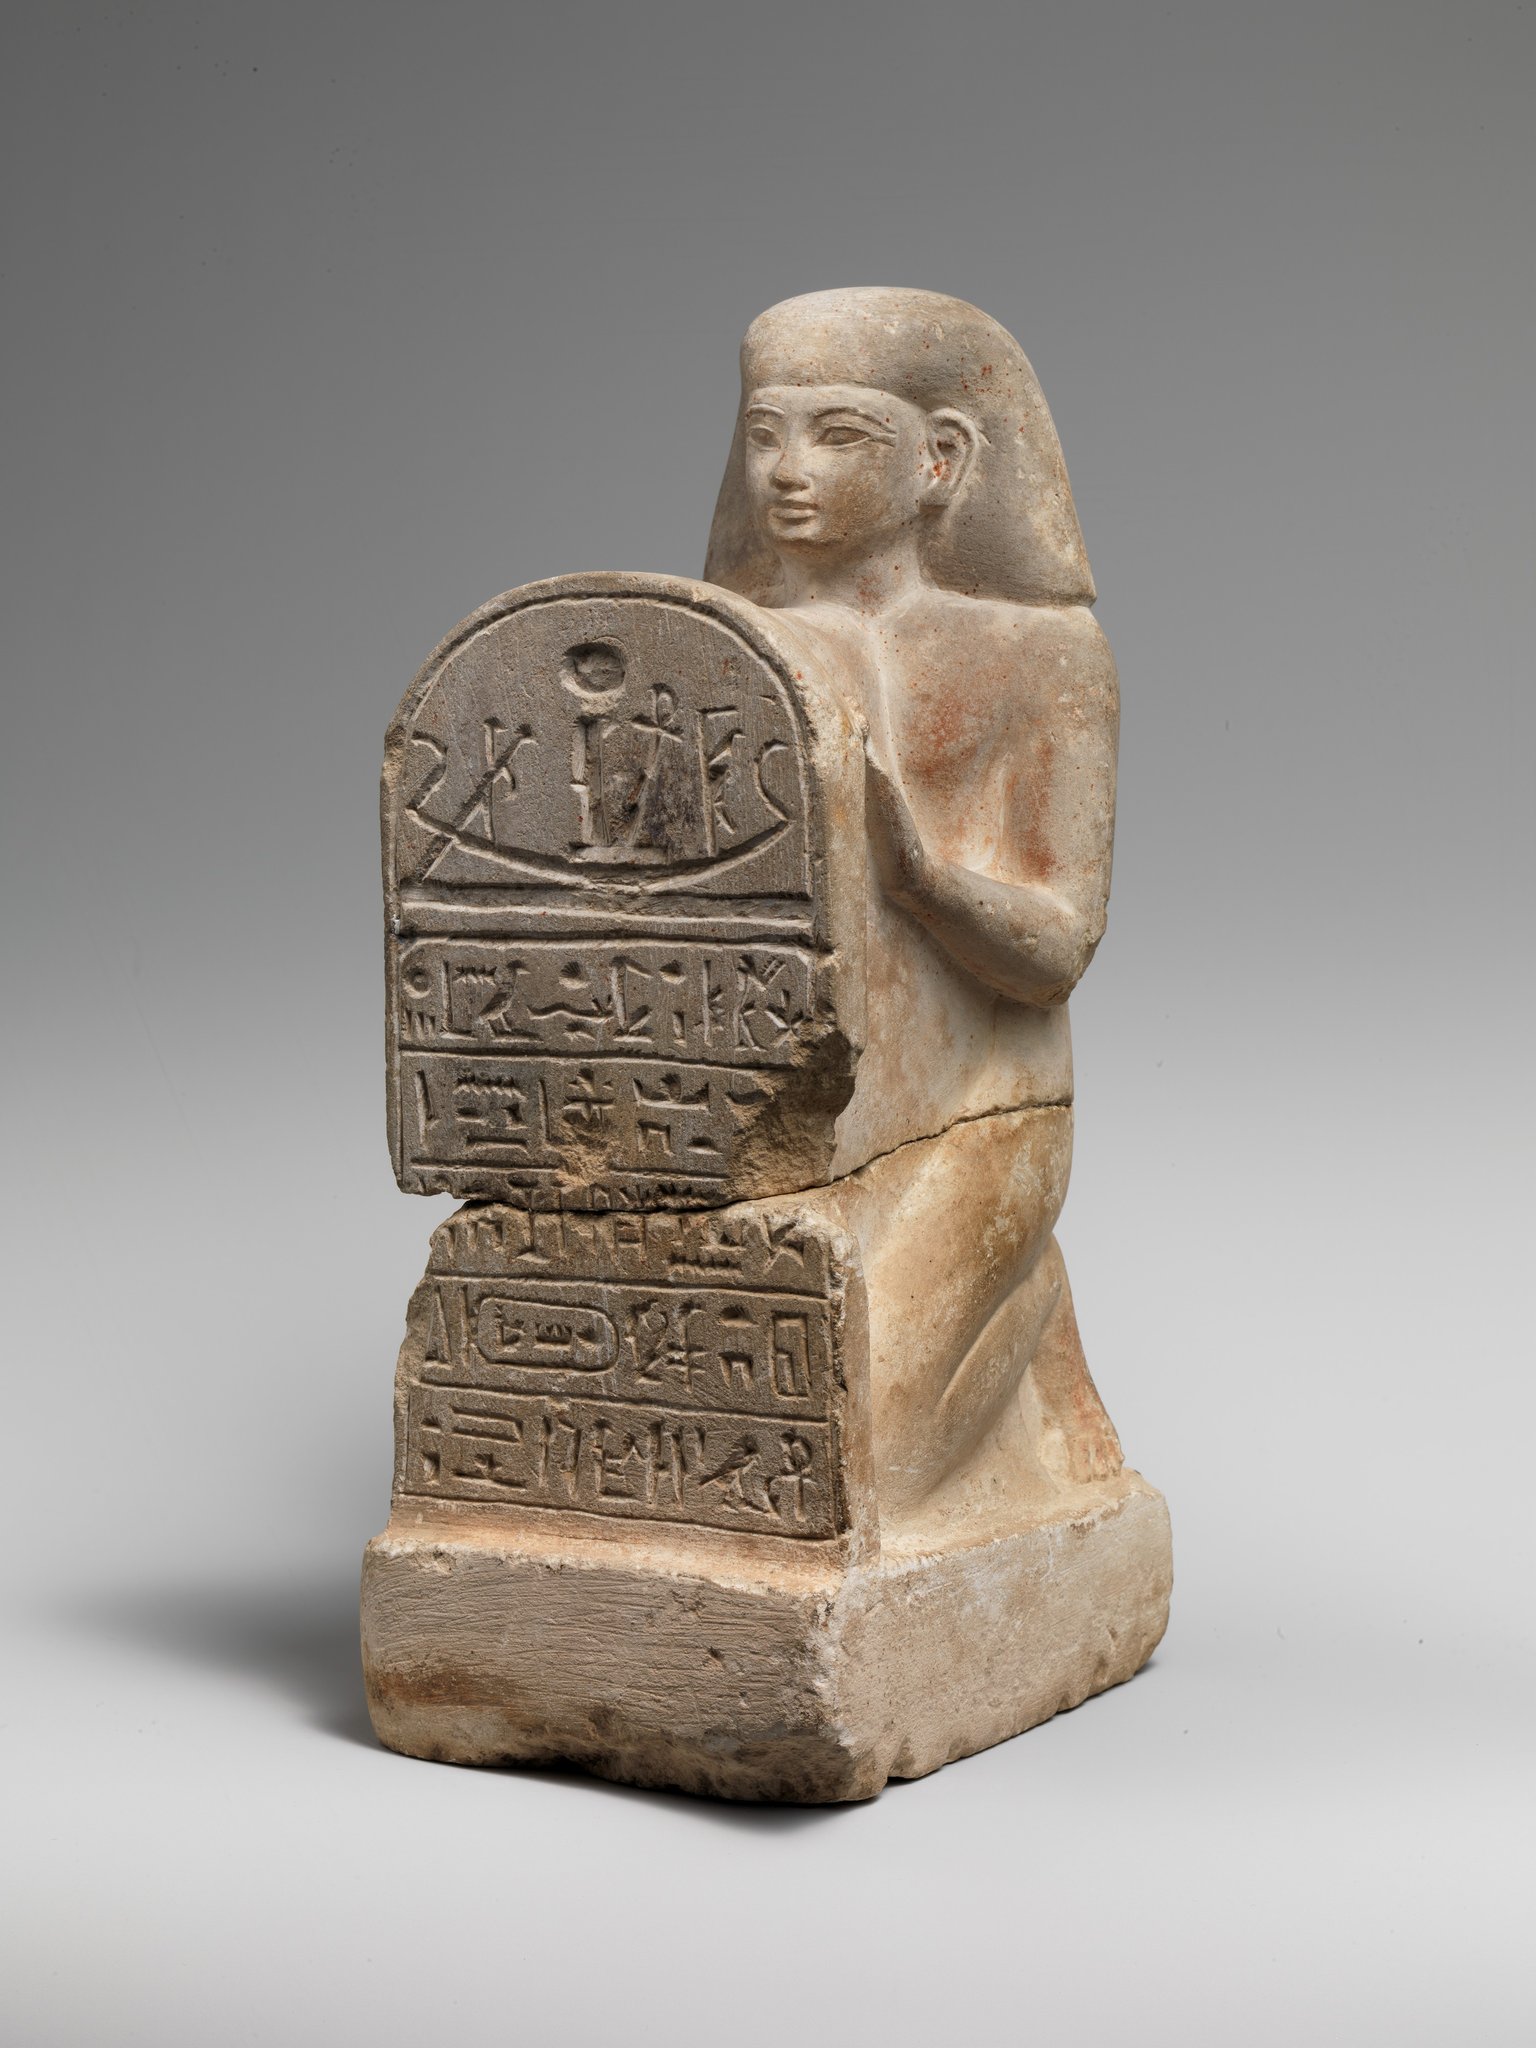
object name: bay, stela, stelephorous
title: Stelophorous Statue of Bay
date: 1294-1250 BCE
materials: limestone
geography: egypt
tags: men,hieroglyphs